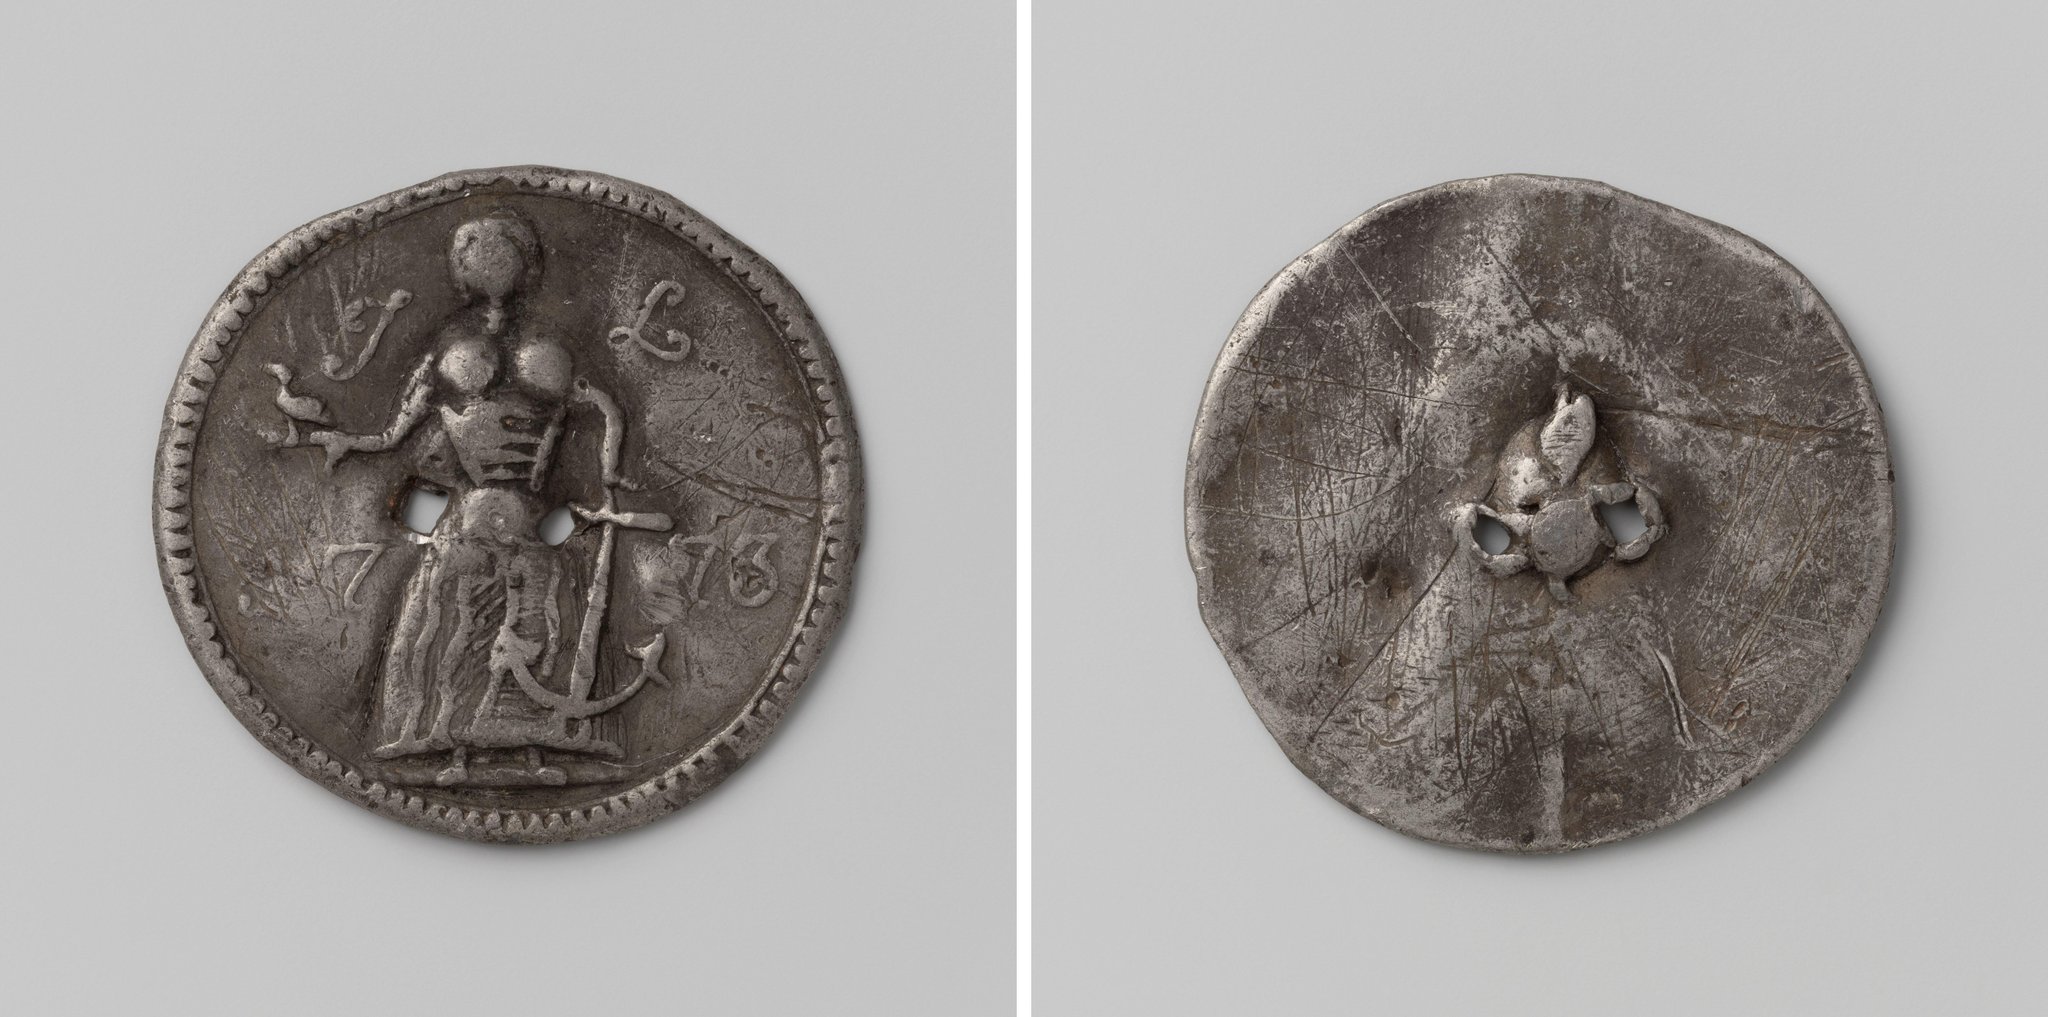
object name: medal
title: De Hoop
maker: Anonymous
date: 1773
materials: lead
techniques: casting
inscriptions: date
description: Eenzijdige loden penning met twee gaten erin. Voorzijde: staande vrouw met vogel op uitgestrekte rechter- en anker in linkerhand; ter weerszijden van hoofd: letters I en L, daaronder jaartal binnen geribbelde rand. Keerzijde: blanco.